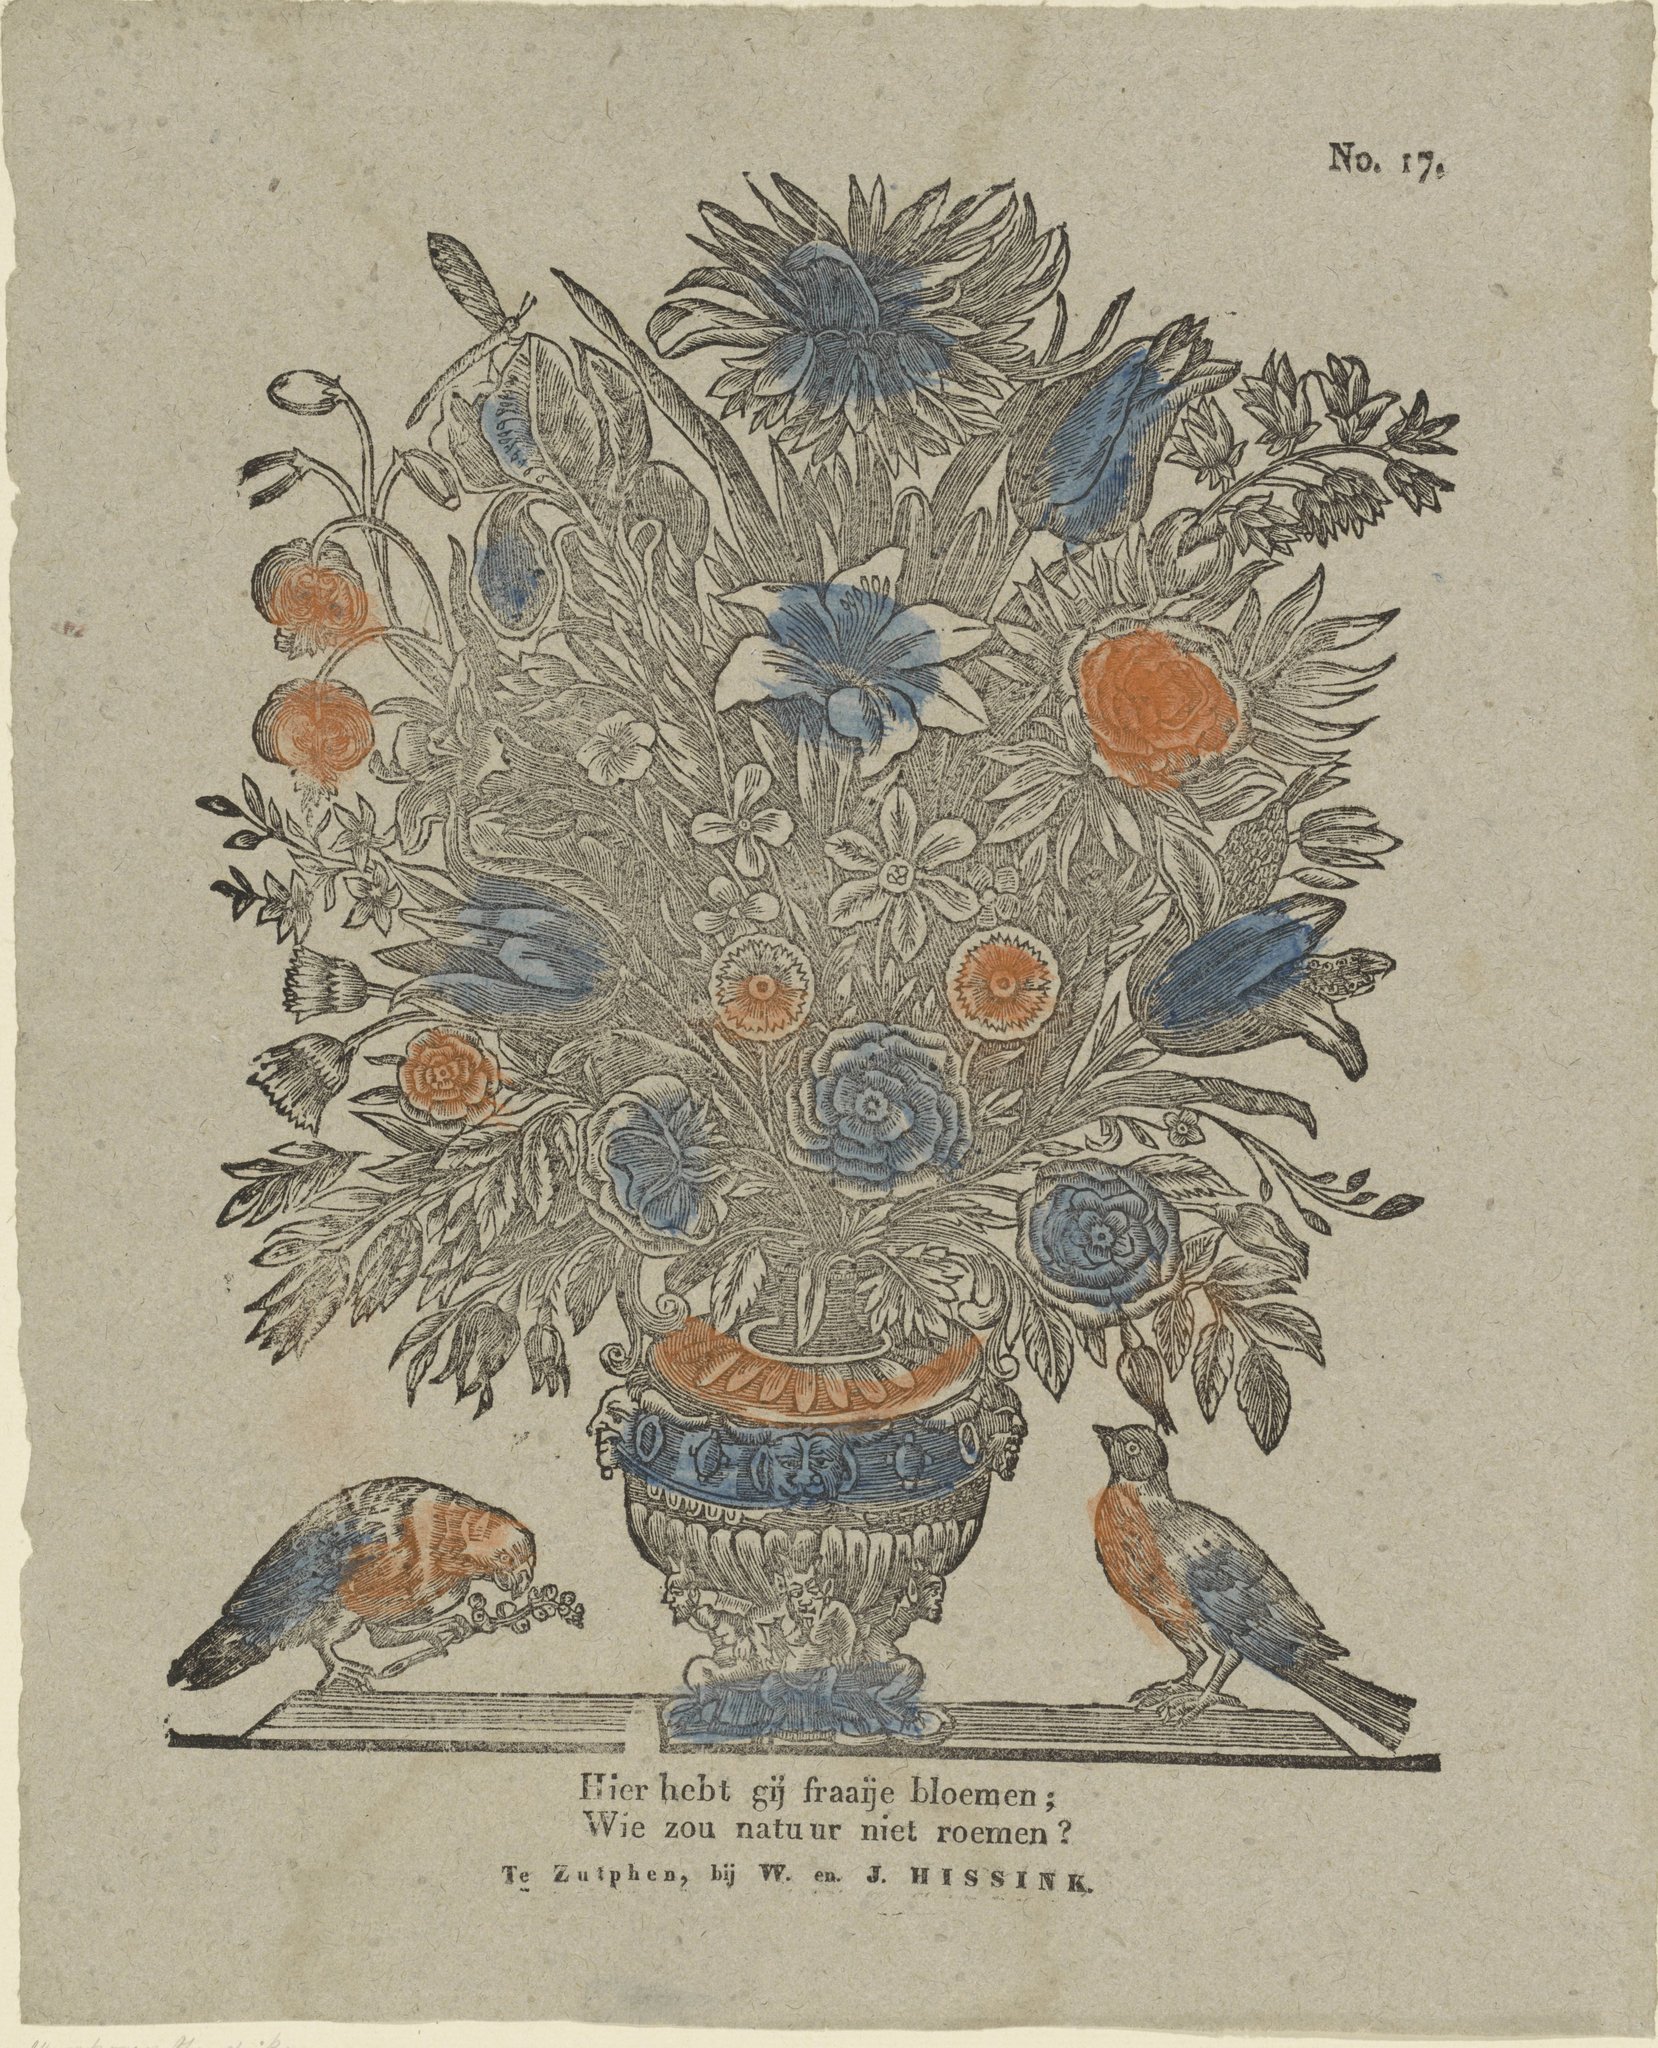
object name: popular print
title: Hier hebt gij fraaije bloemen; / Wie zou natuur niet roemen?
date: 1832-1850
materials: paper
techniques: colour, letterpress printing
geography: zutphen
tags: birds, flowers in a vase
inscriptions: collector's mark: Lugt 2760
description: Een vaas met een bos bestaande uit verschillende bloemen, waaronder een roos, een tulp en een viooltje. Aan weerszijden van de vaas een vogel. Genummerd rechtsboven: No. 17.